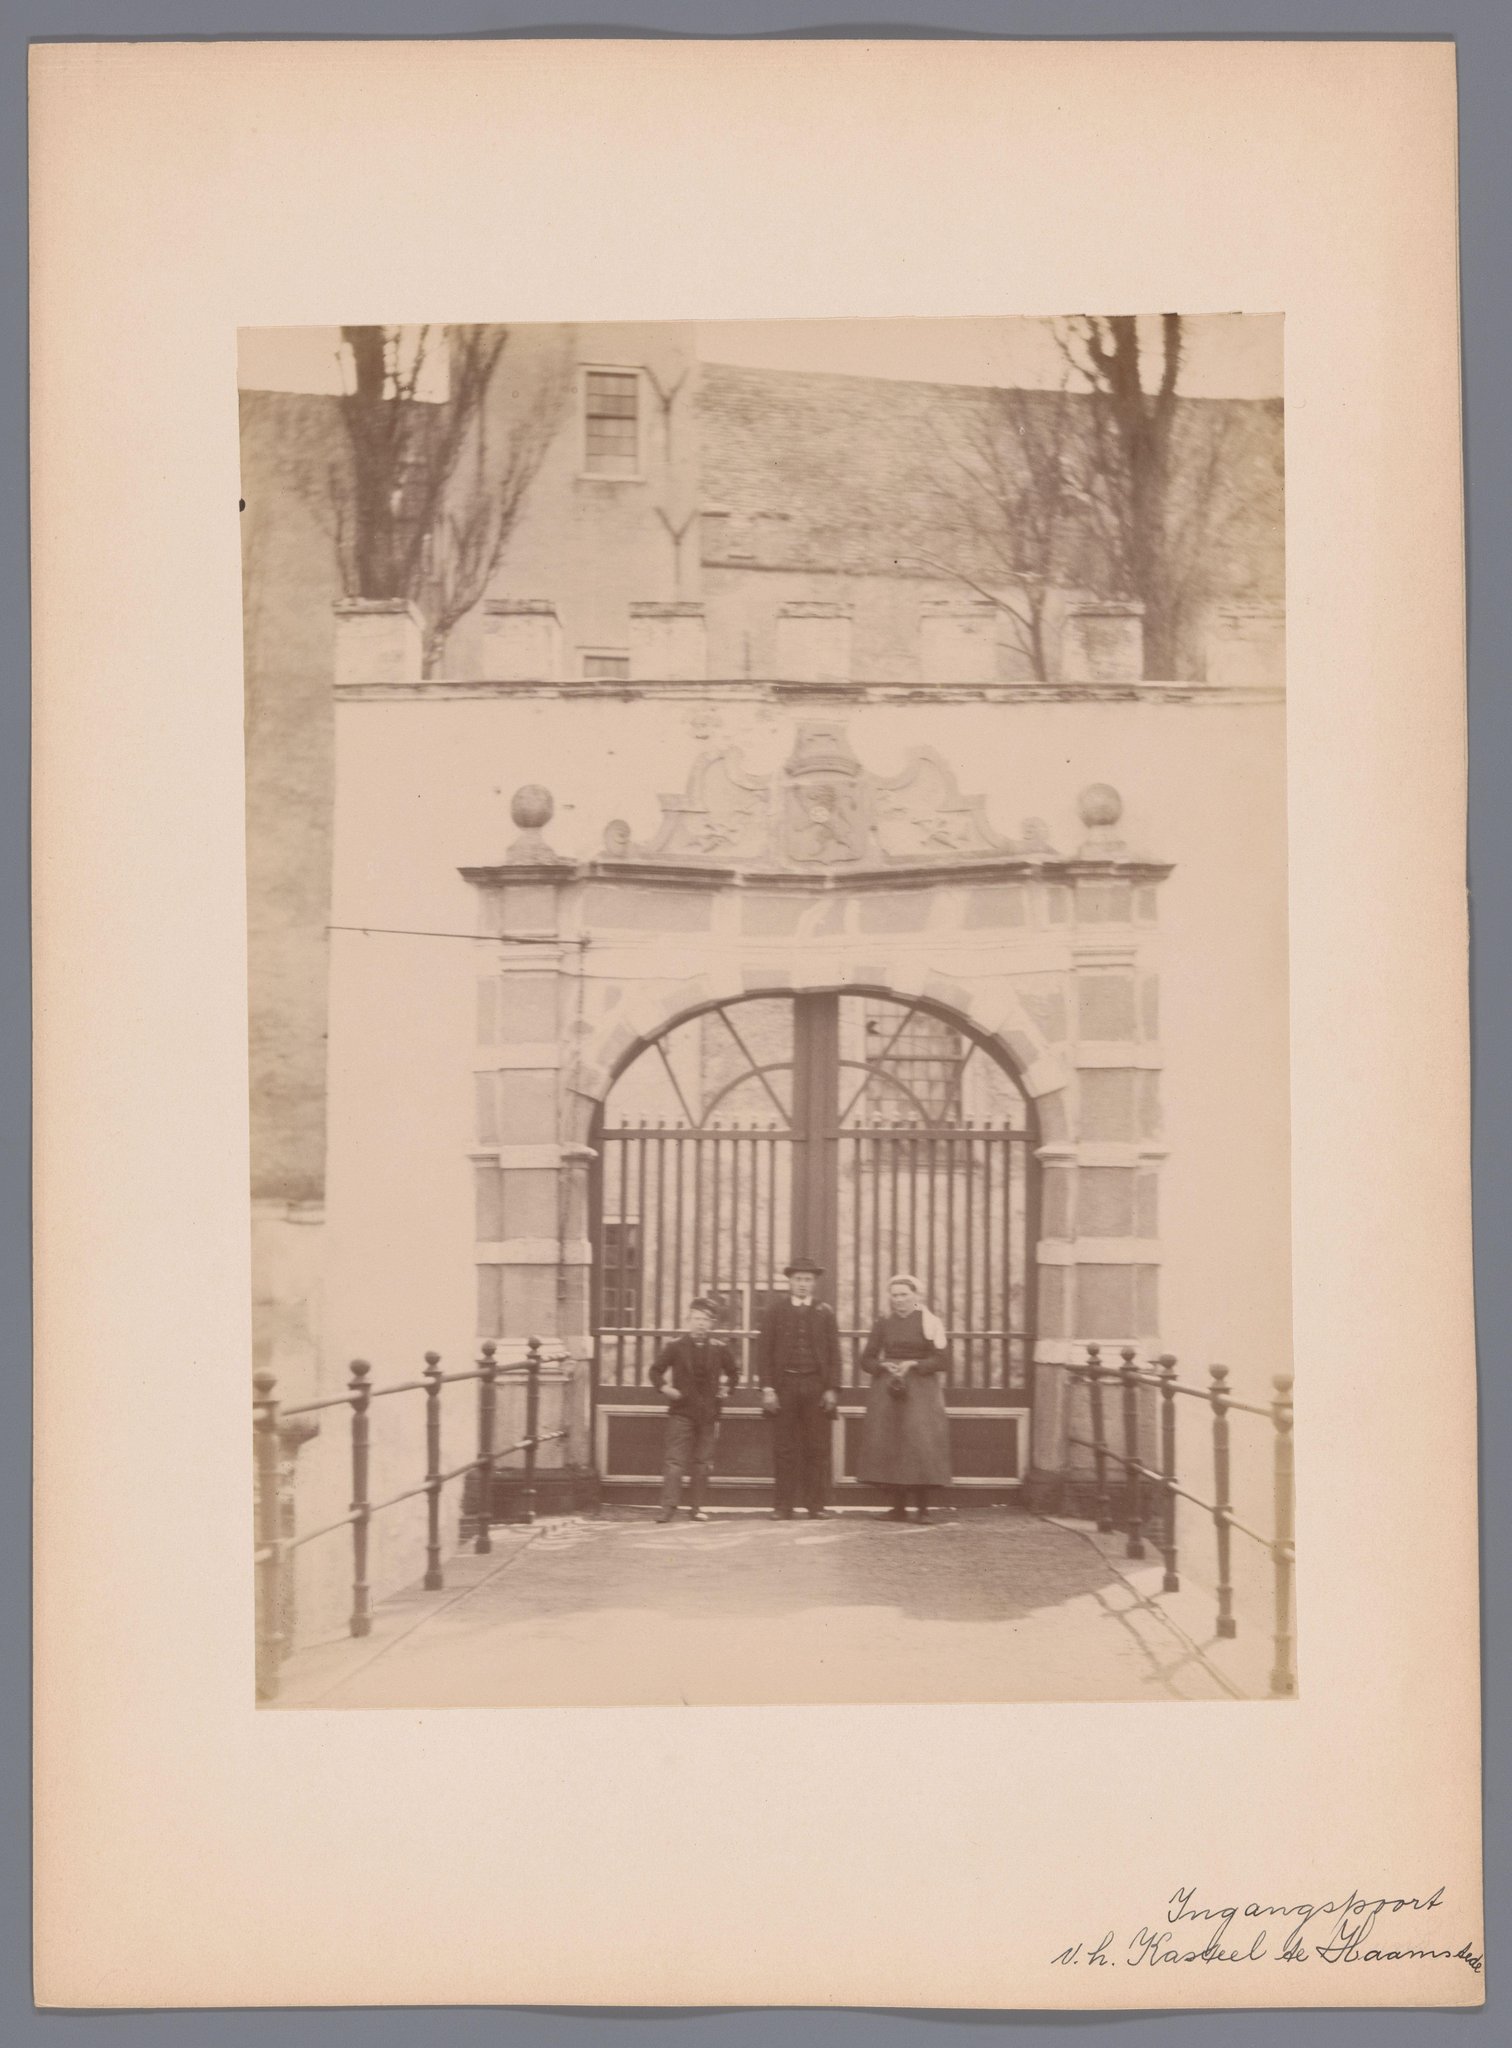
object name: photograph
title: Poort van Slot Haamstede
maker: anoniem (monumentenzorg)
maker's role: fotograaf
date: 1890-1920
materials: cardboard, photographic support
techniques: albumen print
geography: haamstede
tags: castle, gate, entrance, slot haamstede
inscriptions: annotation: ‘Ingangspoort/ v.h. Kasteel te Haamstede’, annotation: ‘Ingangspoort v/h Kateel Haamstede/ Zeeland’